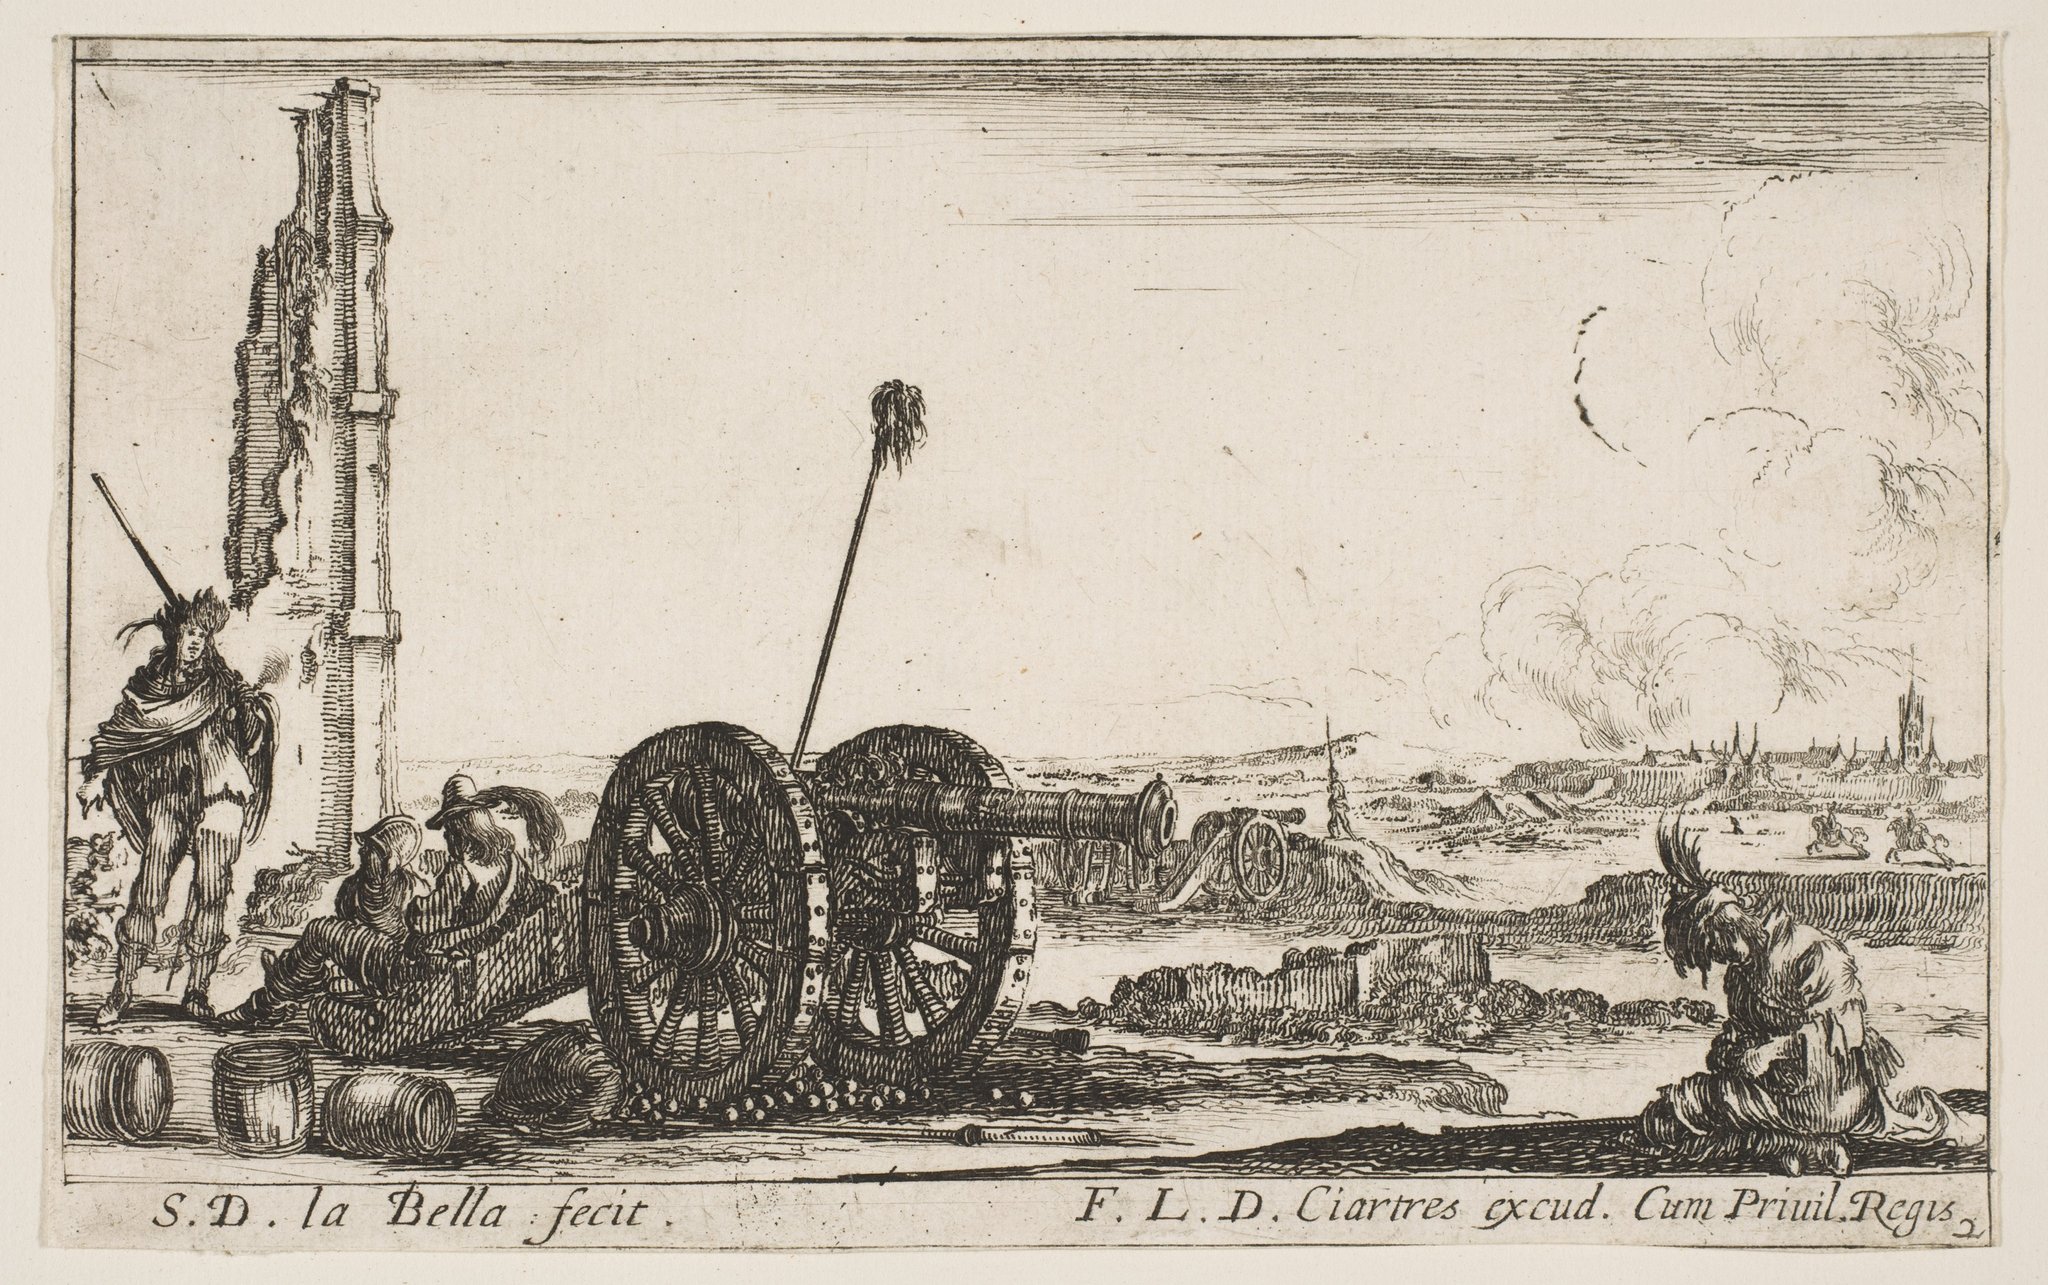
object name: print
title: A cannon to the left, a town in the background, plate 2 from "Various Military Caprices" (Varii capricci militari)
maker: stefano della bella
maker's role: artist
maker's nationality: italian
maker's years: 1610-1664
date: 1641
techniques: etching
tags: towns,cannons,men,horses